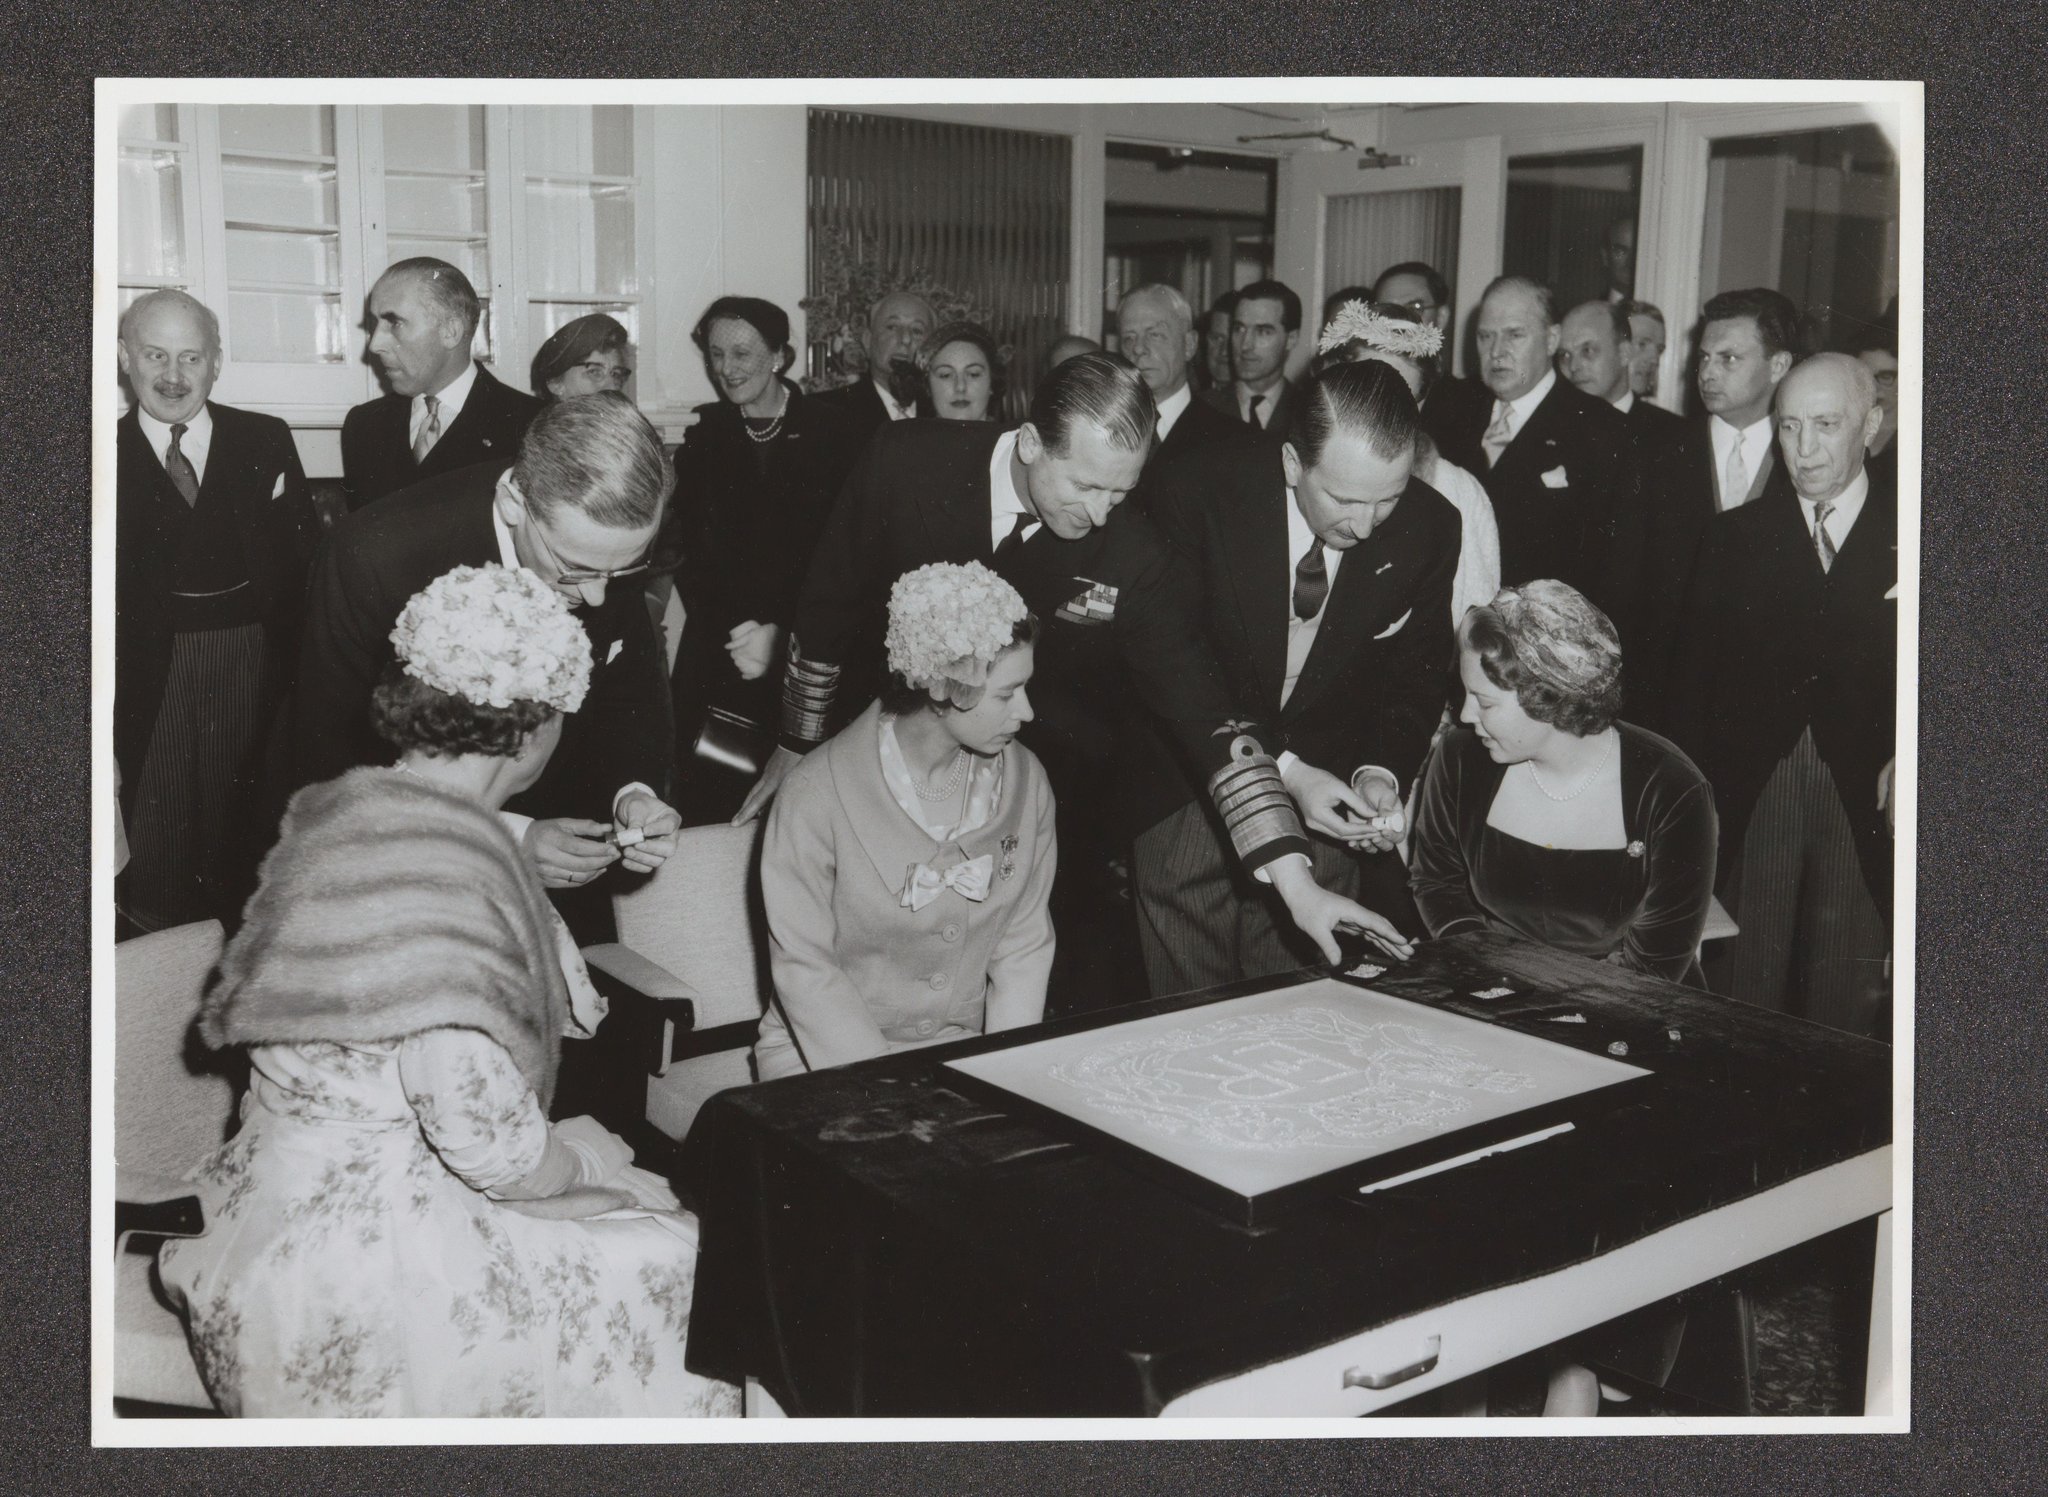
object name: photograph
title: Koningin Elizabeth, Koningin Juliana en prinses Beatrix bekijken diamanten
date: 1958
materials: paper, photographic support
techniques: gelatin silver print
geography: amsterdam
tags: beatrix (koningin der nederlanden), juliana of the netherlands, amsterdam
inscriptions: inscription: ‘Eng en Ned Kon. paren’, date: ‘25/3 '58’, stamp: ‘Copyright ANEFO Kerkstraat 310 Amsterdam -C No. 94322’